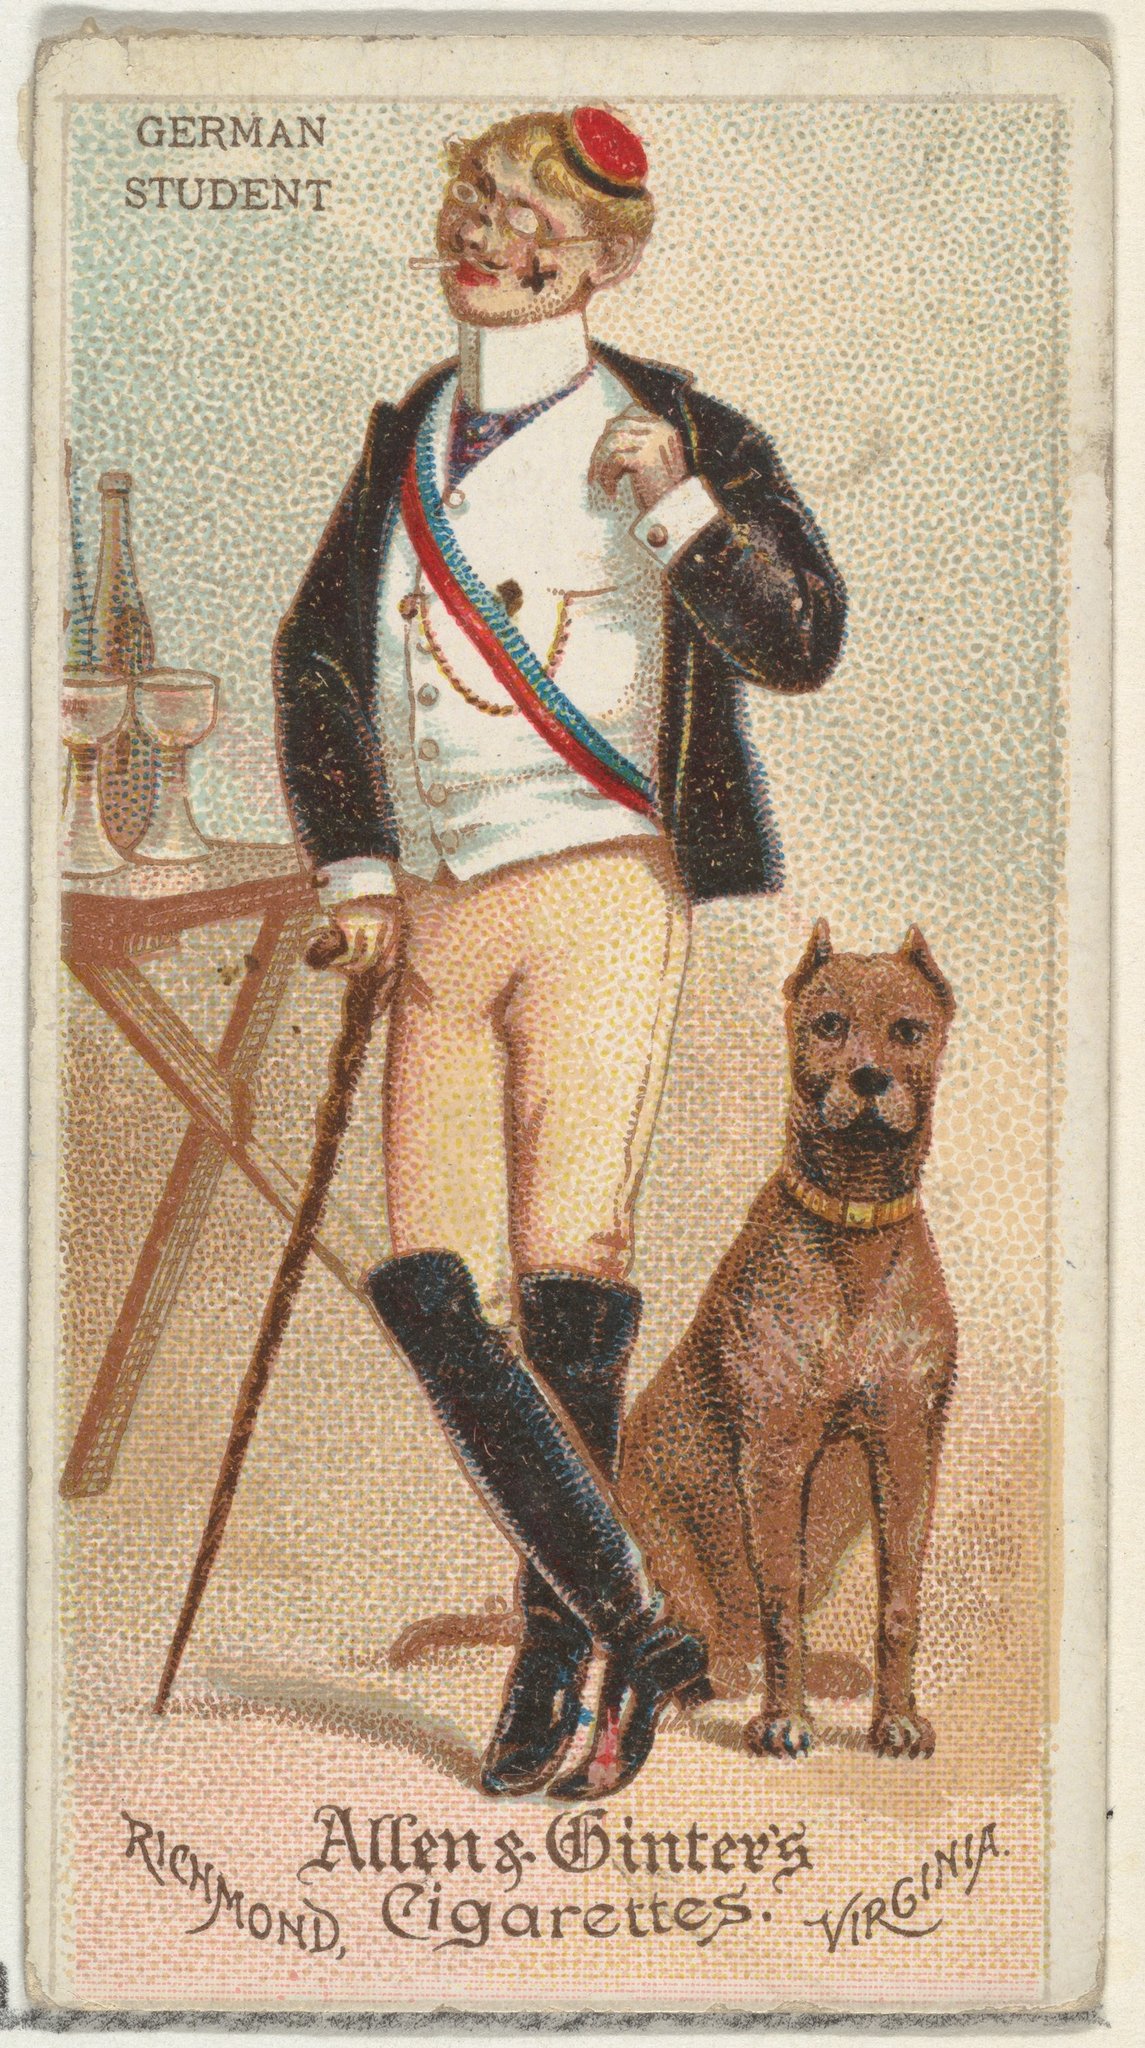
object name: print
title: German Student, from World's Dudes series (N31) for Allen & Ginter Cigarettes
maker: allen & ginter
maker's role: publisher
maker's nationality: american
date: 1888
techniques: color lithograph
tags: men,dogs